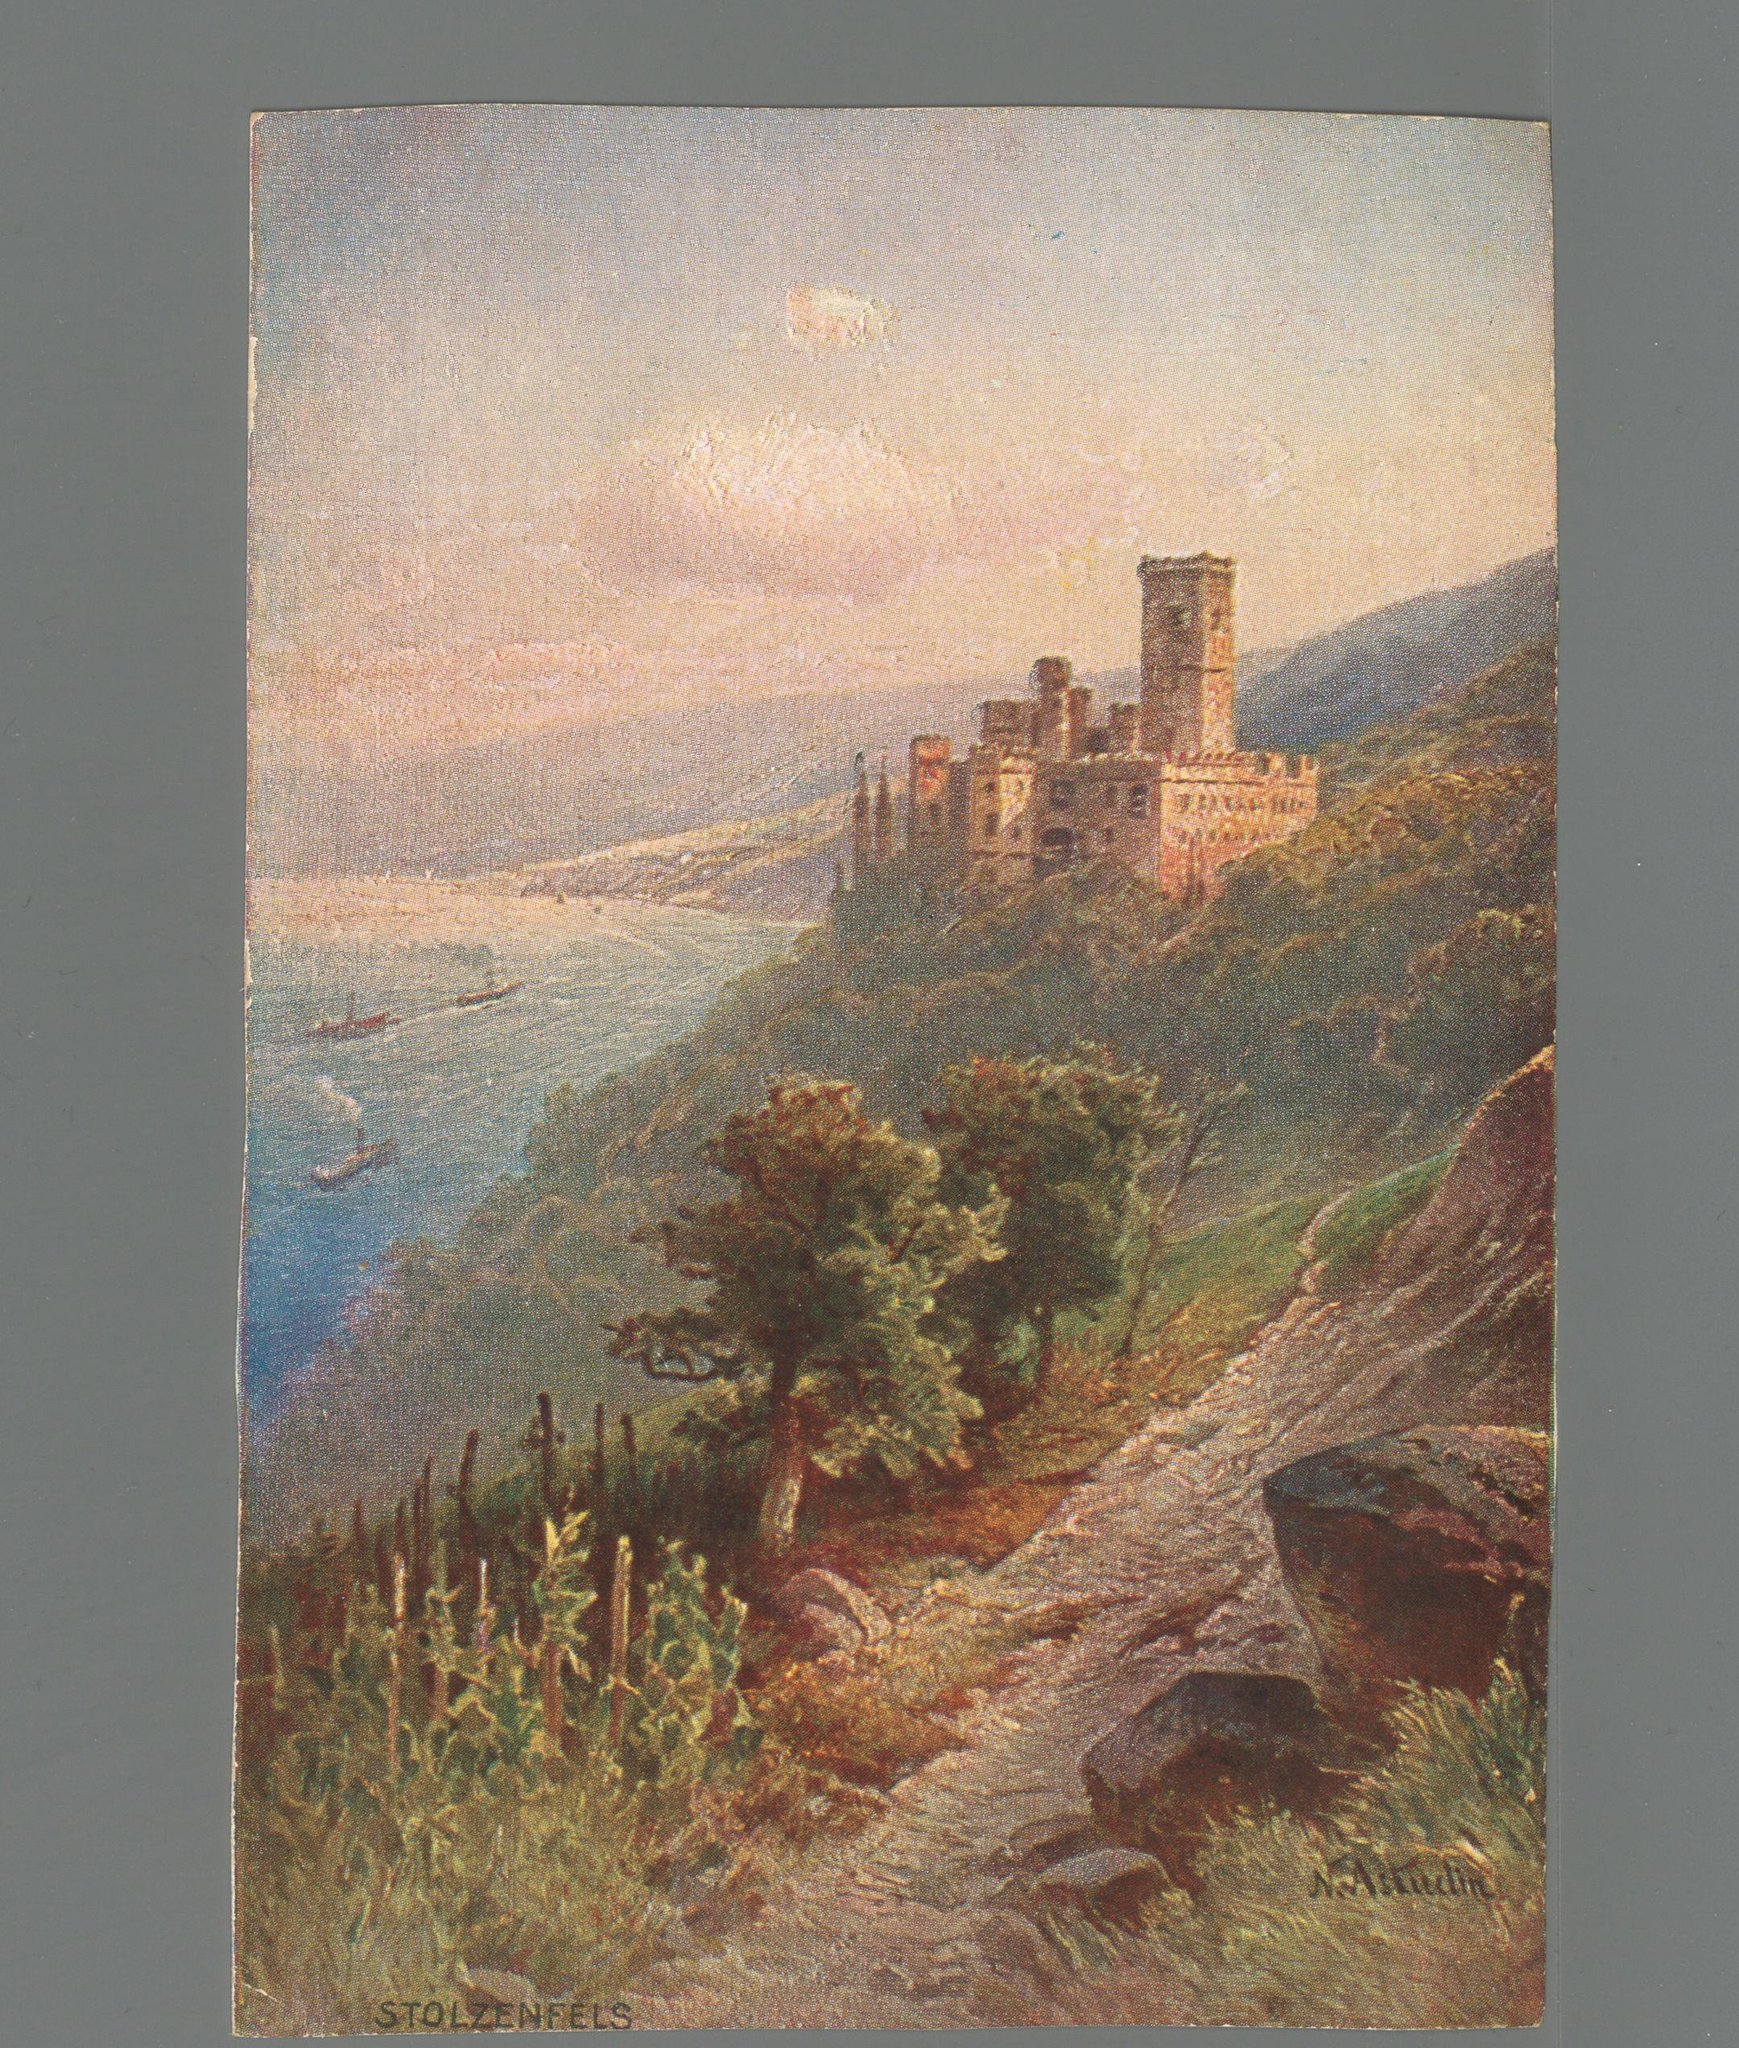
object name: ansichtkaart, prentbriefkaart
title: Stolzenfels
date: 1905-1930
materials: cardboard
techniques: color autotype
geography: cologne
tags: castle, river